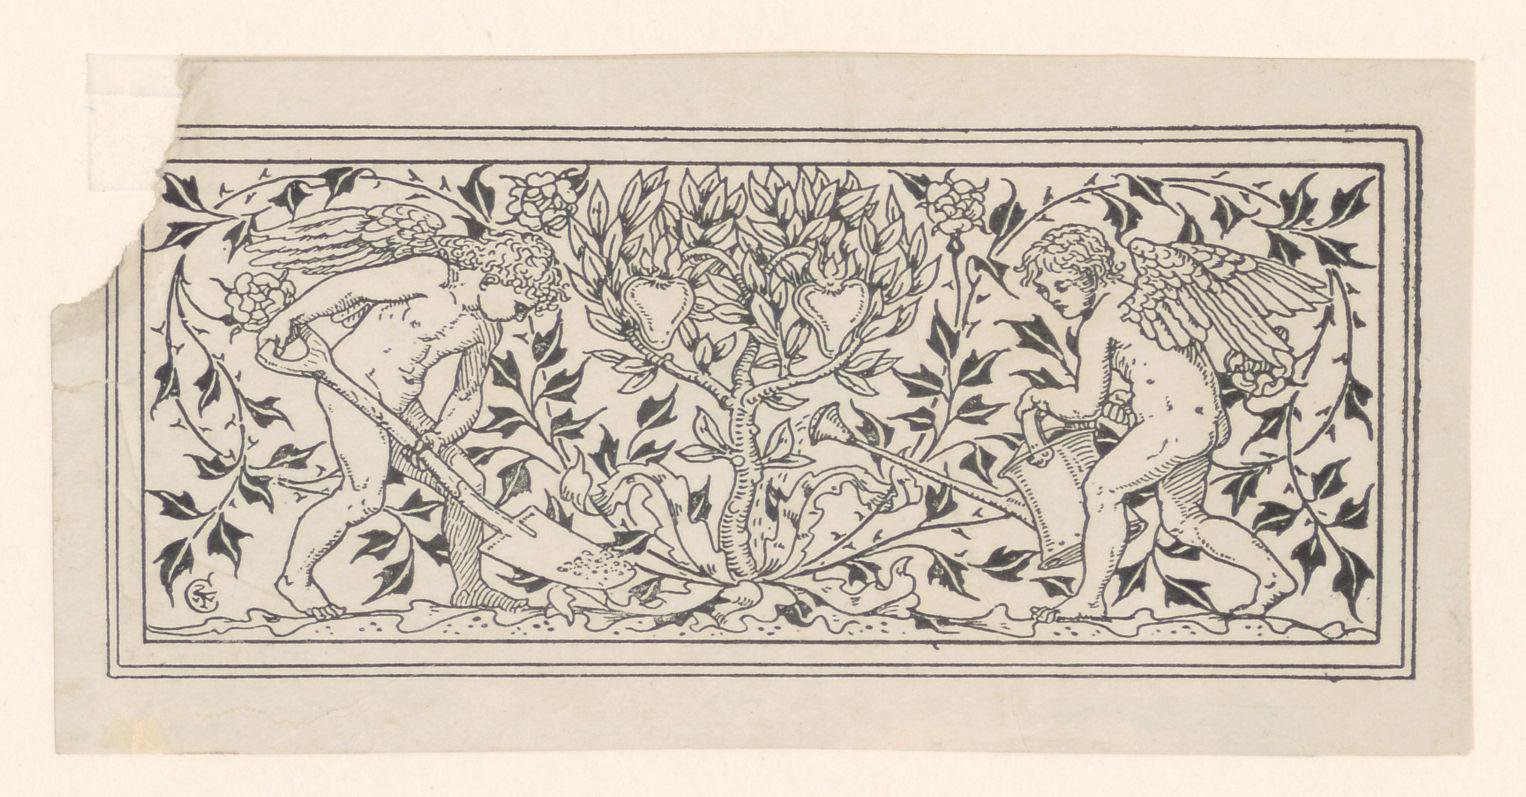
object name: print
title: Twee putti verzorgen een boom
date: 1887-1893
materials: paper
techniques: engraving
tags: trees, gardening, cupids: 'amores', 'amoretti', 'putti'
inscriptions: collector's mark: Lugt 2228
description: De prent is gebruikt in: Crane, Walter. The claims of decorative art. Londen: Lawrence & Bullen, 1892.